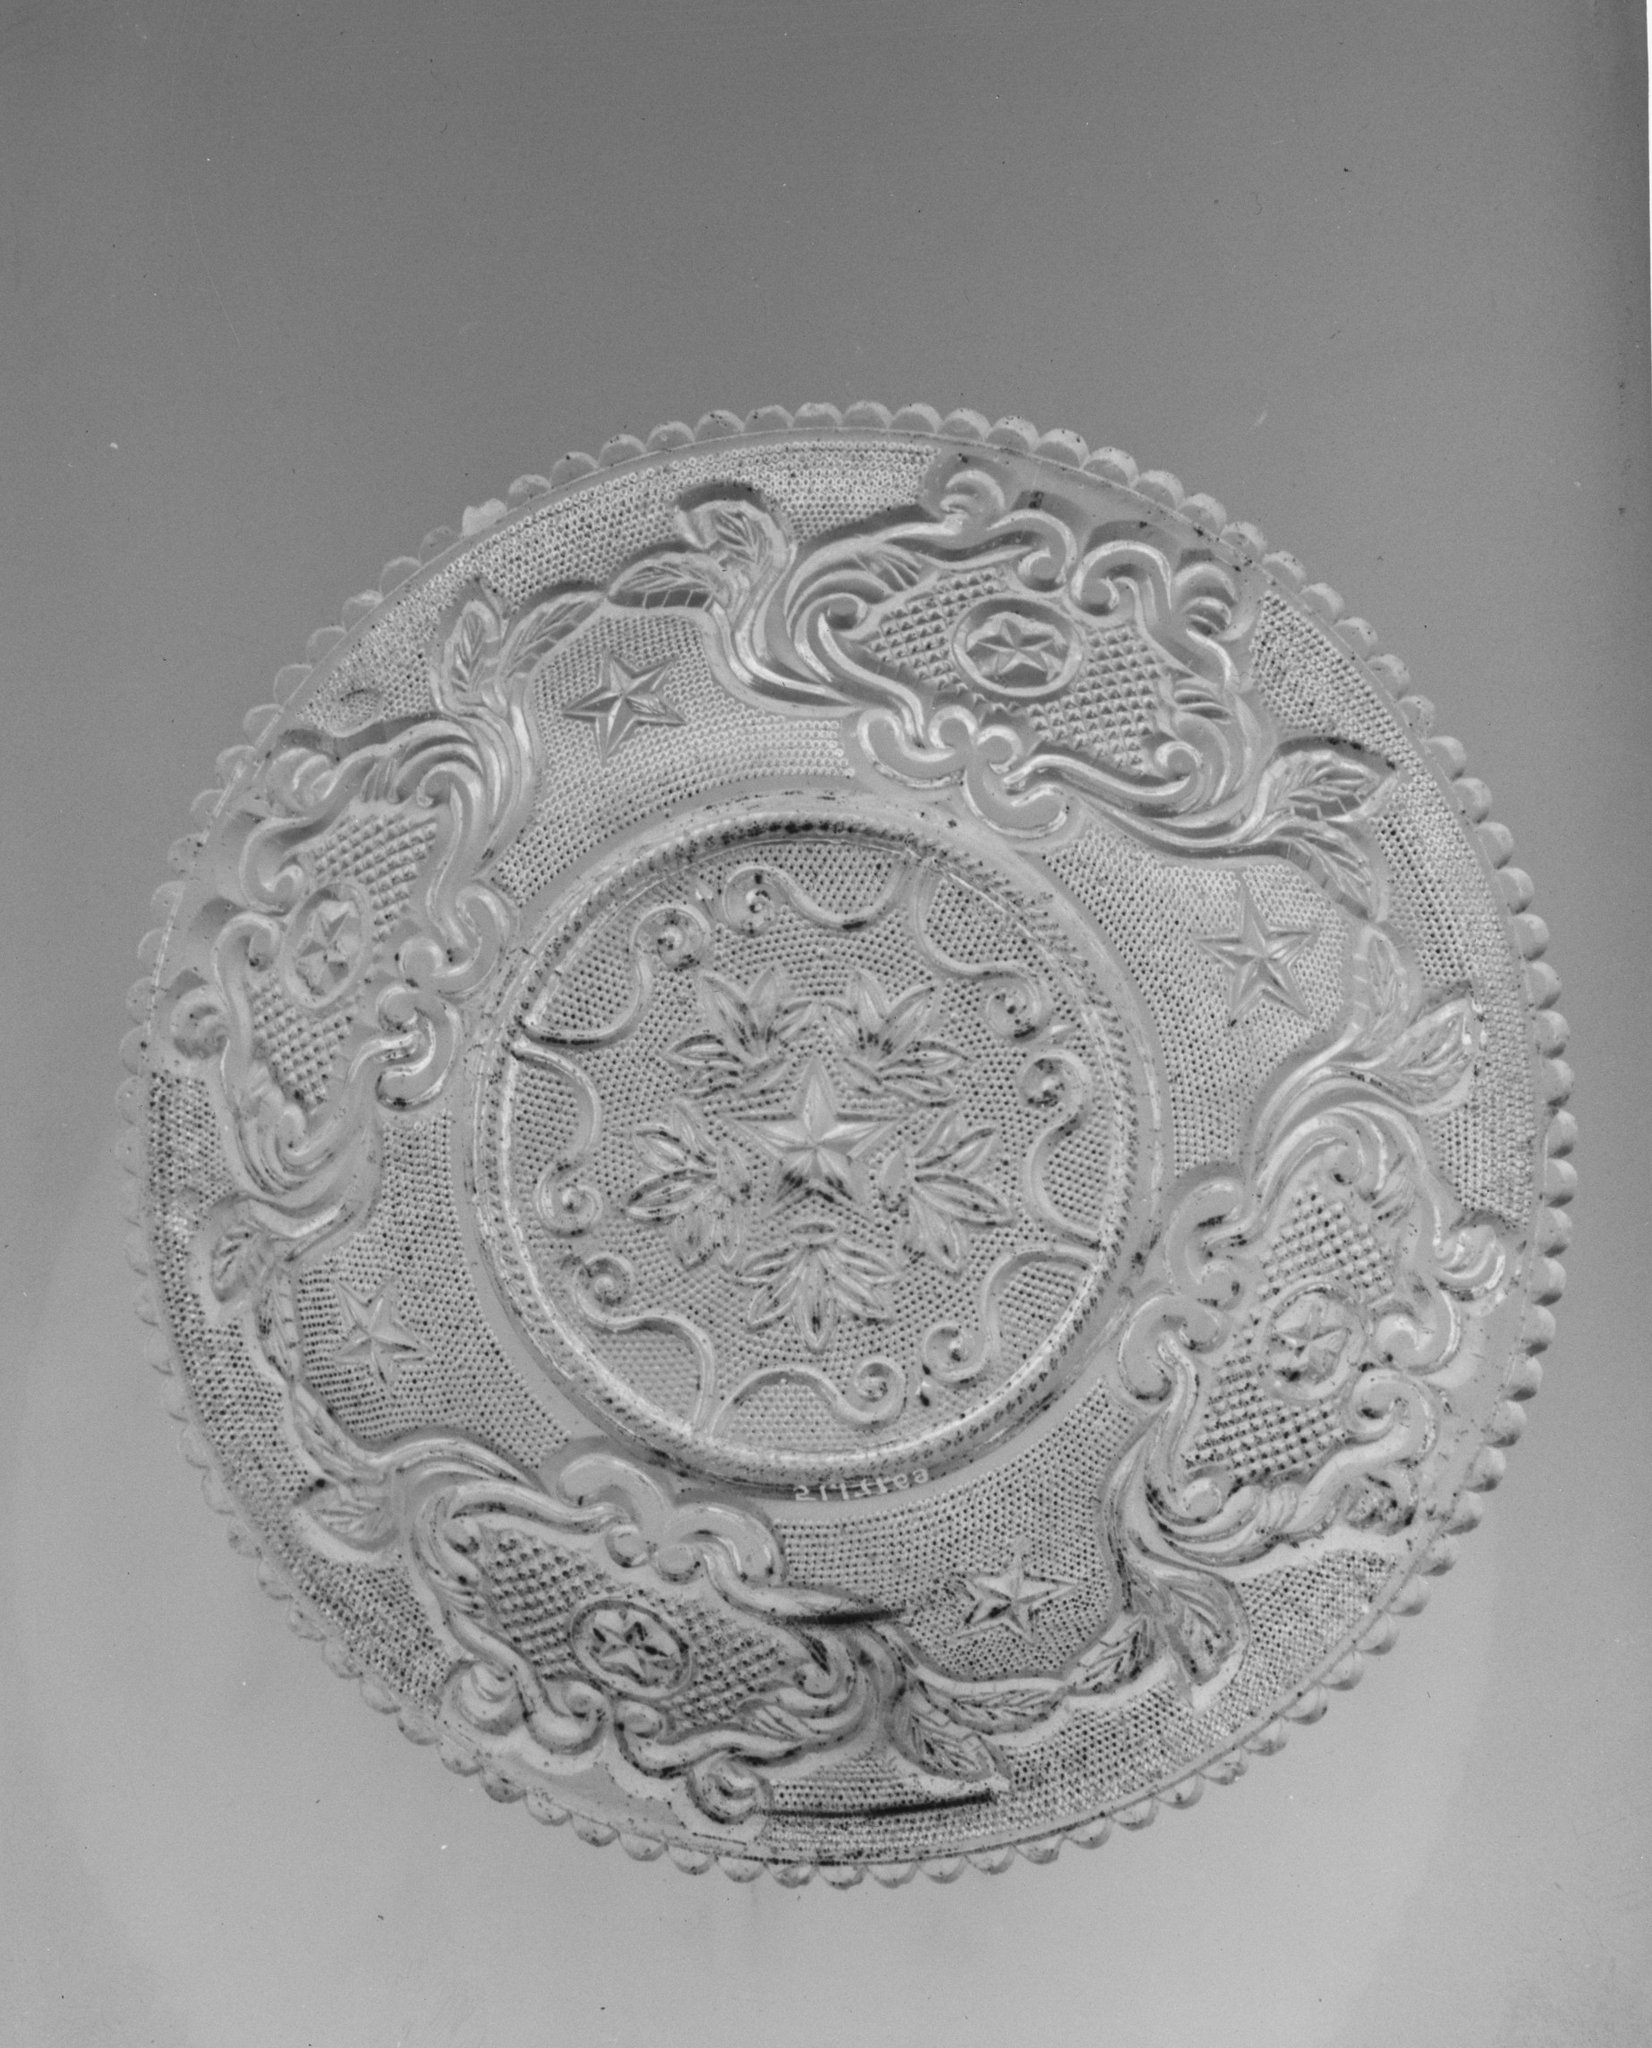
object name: bowl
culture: american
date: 1835-1840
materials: glass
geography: united states